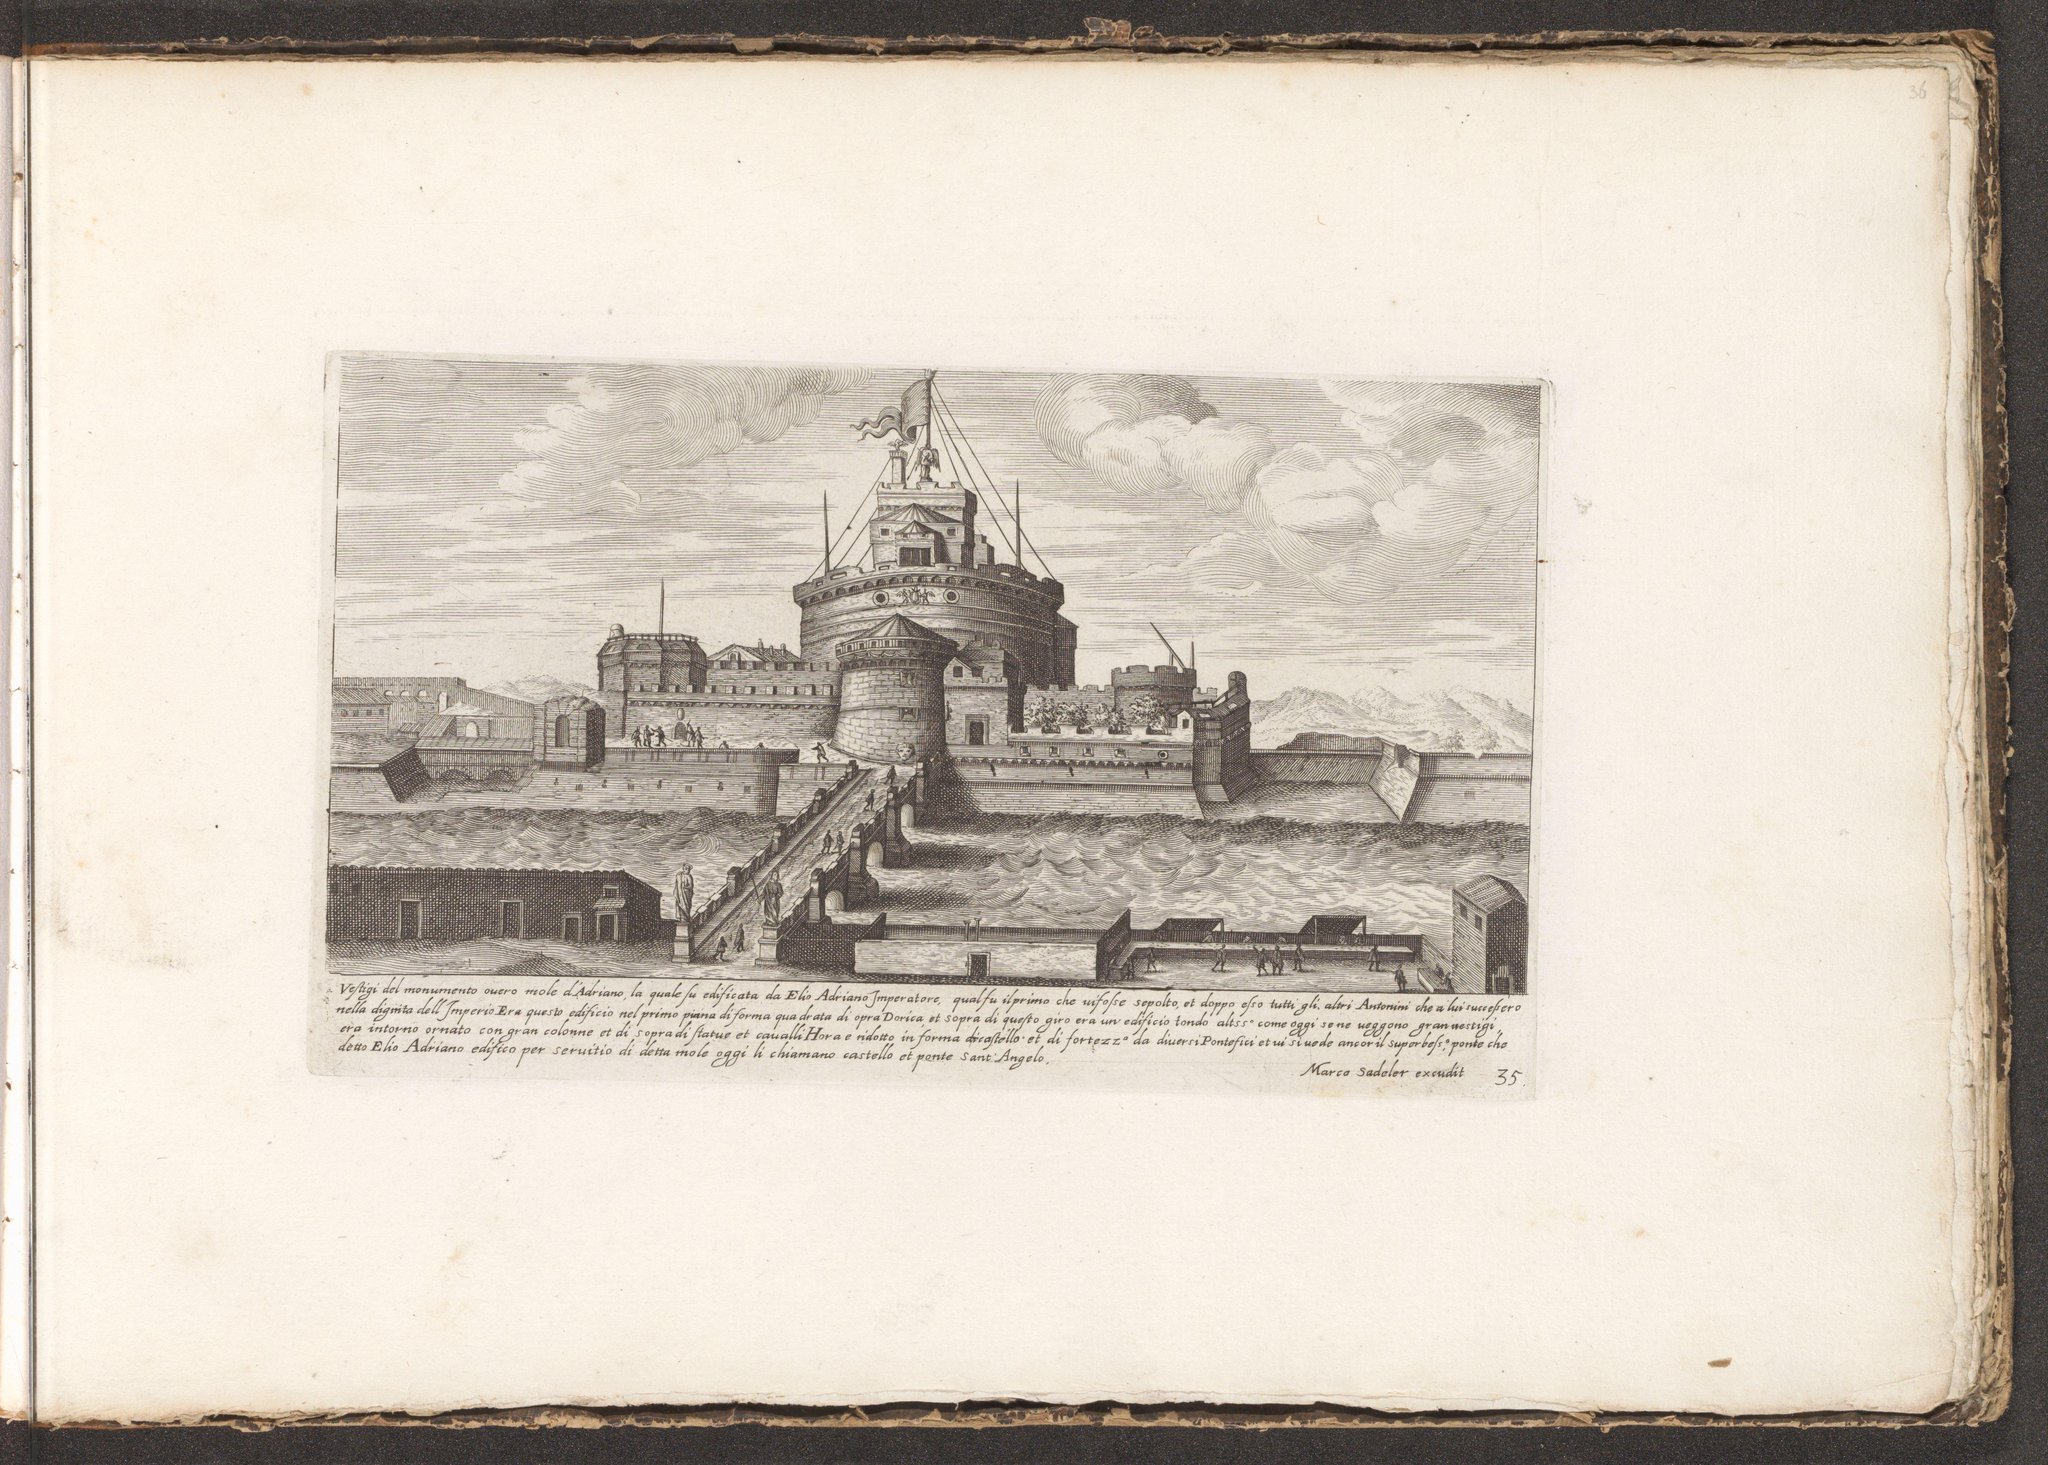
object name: album leaf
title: Vestigi delle antichita di Roma, Tivoli, Pozzuolo et altri luochi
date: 1680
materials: paper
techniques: engraving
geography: rome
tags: rome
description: De Engelenburcht, oorspronkelijk Moles Hadriani ('het gevaarte van Hadrianus'), het grote mausoleum van keizer Hadrianus. In de ondermarge vier regels tekst in het Italiaans. De prent maakt deel uit van een album.